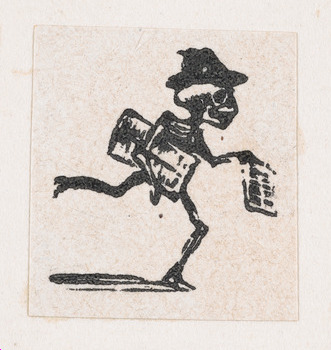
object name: print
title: A skeleton wearing a hat, holding newspapers and running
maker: josé guadalupe posada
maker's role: artist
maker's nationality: mexican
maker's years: 1852-1913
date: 1880-1910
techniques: lithography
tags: skeletons